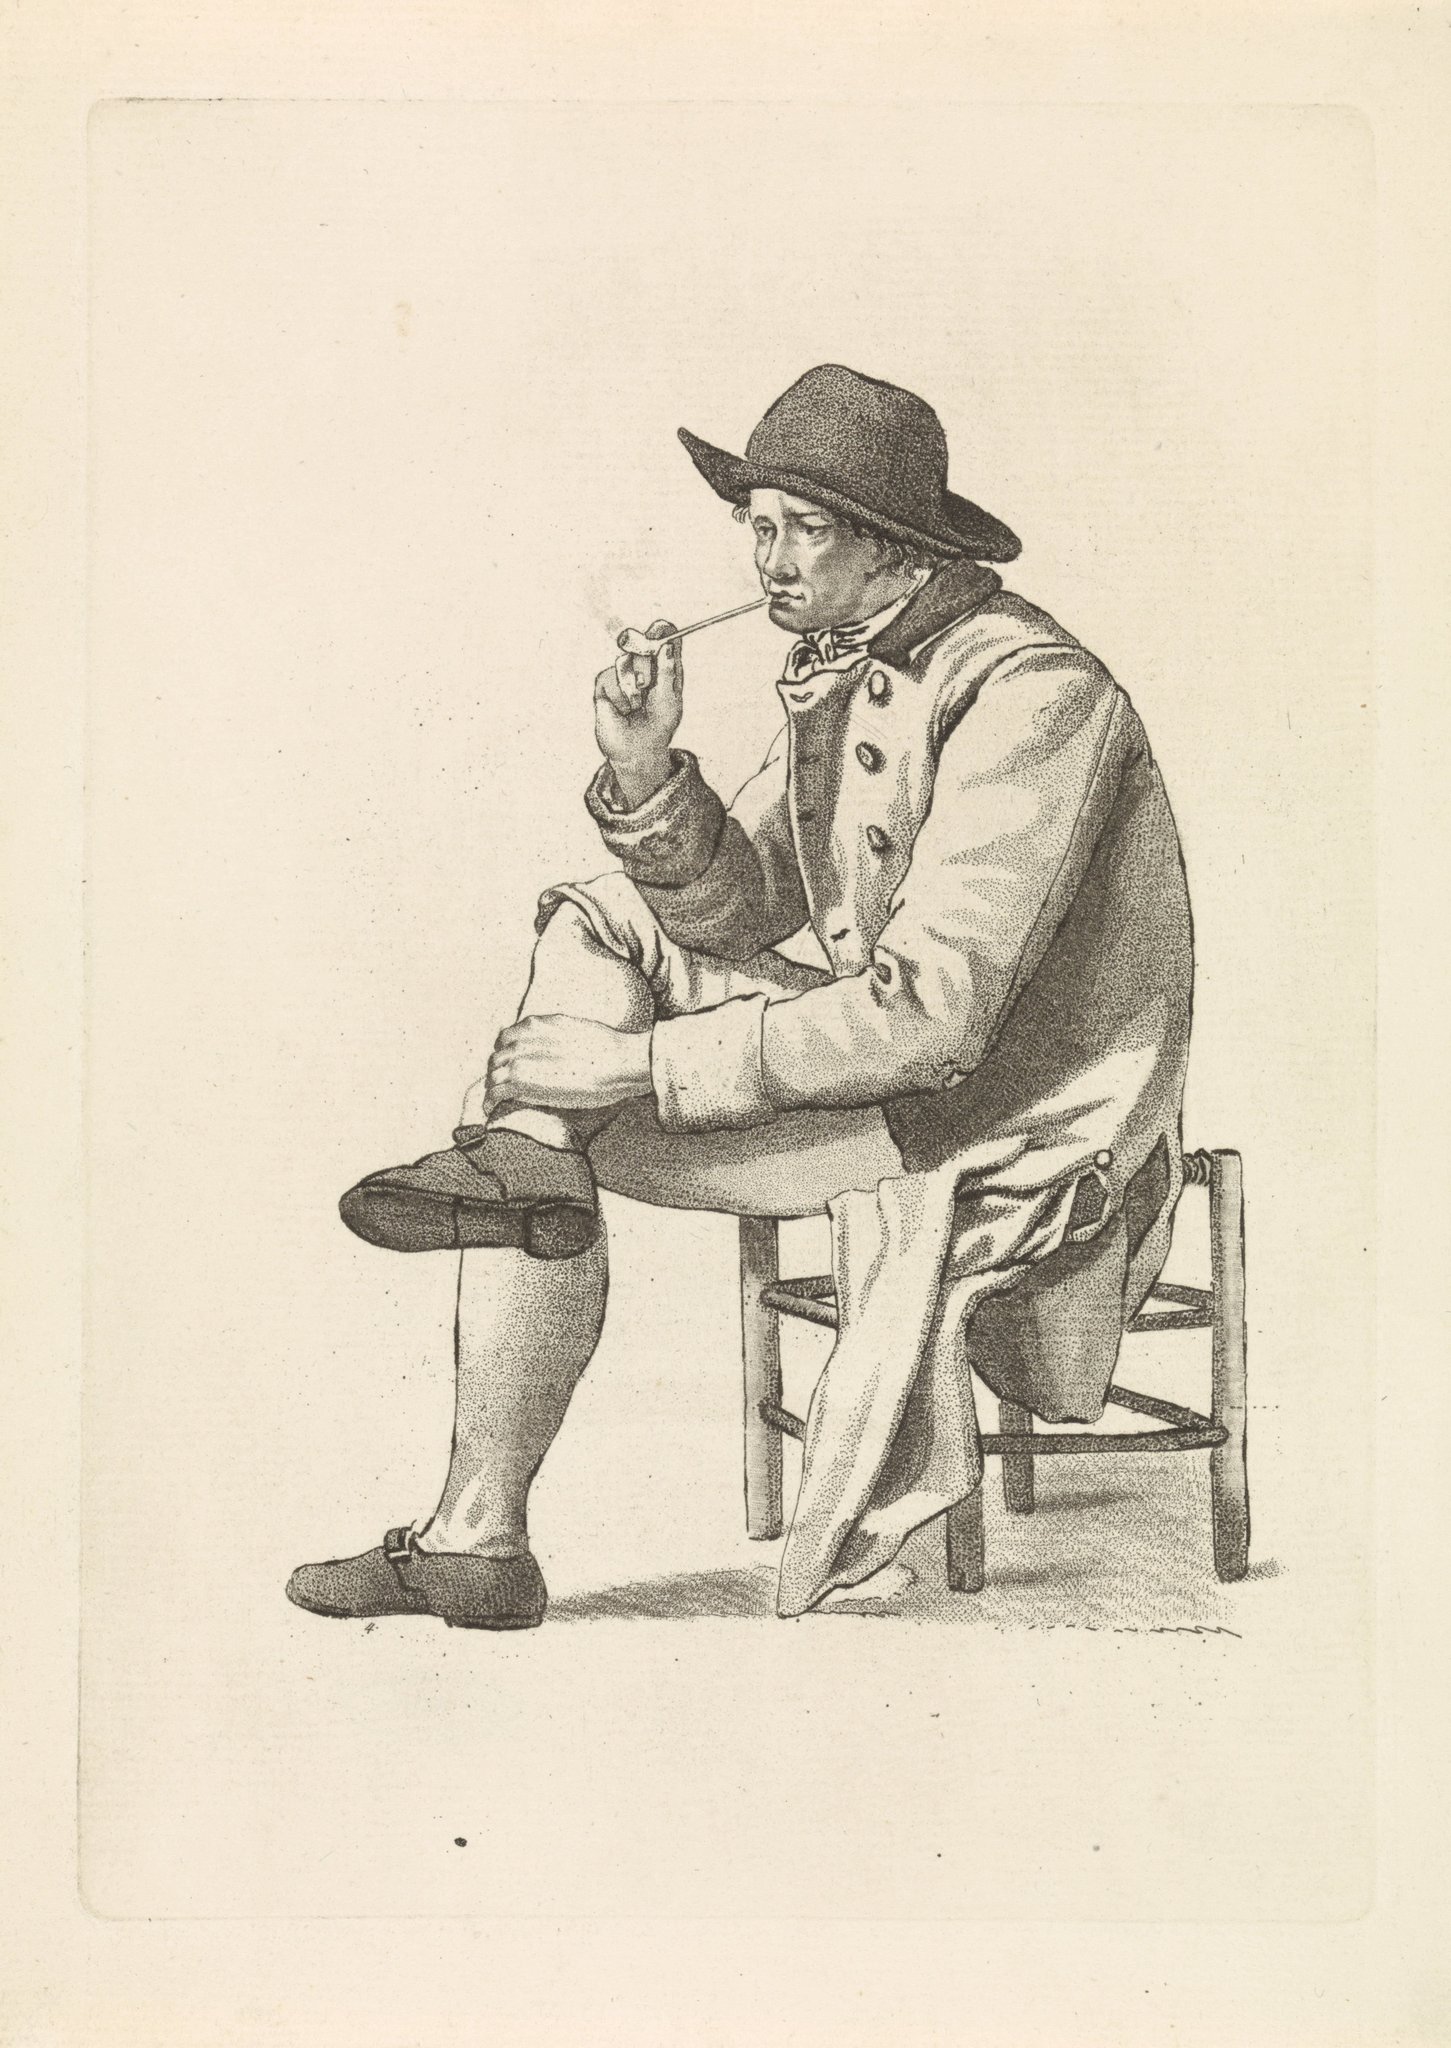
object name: print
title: Pijprokende man zittend op een kruk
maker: mathias de sallieth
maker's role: print maker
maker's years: 1749-1791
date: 1772-1791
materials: paper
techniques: printmaking, etching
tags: pipe ~ tobacco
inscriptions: collector's mark: Lugt 2228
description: De prent verscheen vanaf 1818 tevens als onderdeel van een 33-delige reeks prenten door Mathias de Sallieth, samengebonden in: Perkois, Jacobus, Prins, Johannes Huibert. Verzameling van verschillende gekleede mans- en vrouwenstanden, ter oefening van jonge schilders en liefhebbers. Rotterdam: Johannes Immerzeel, 1818.